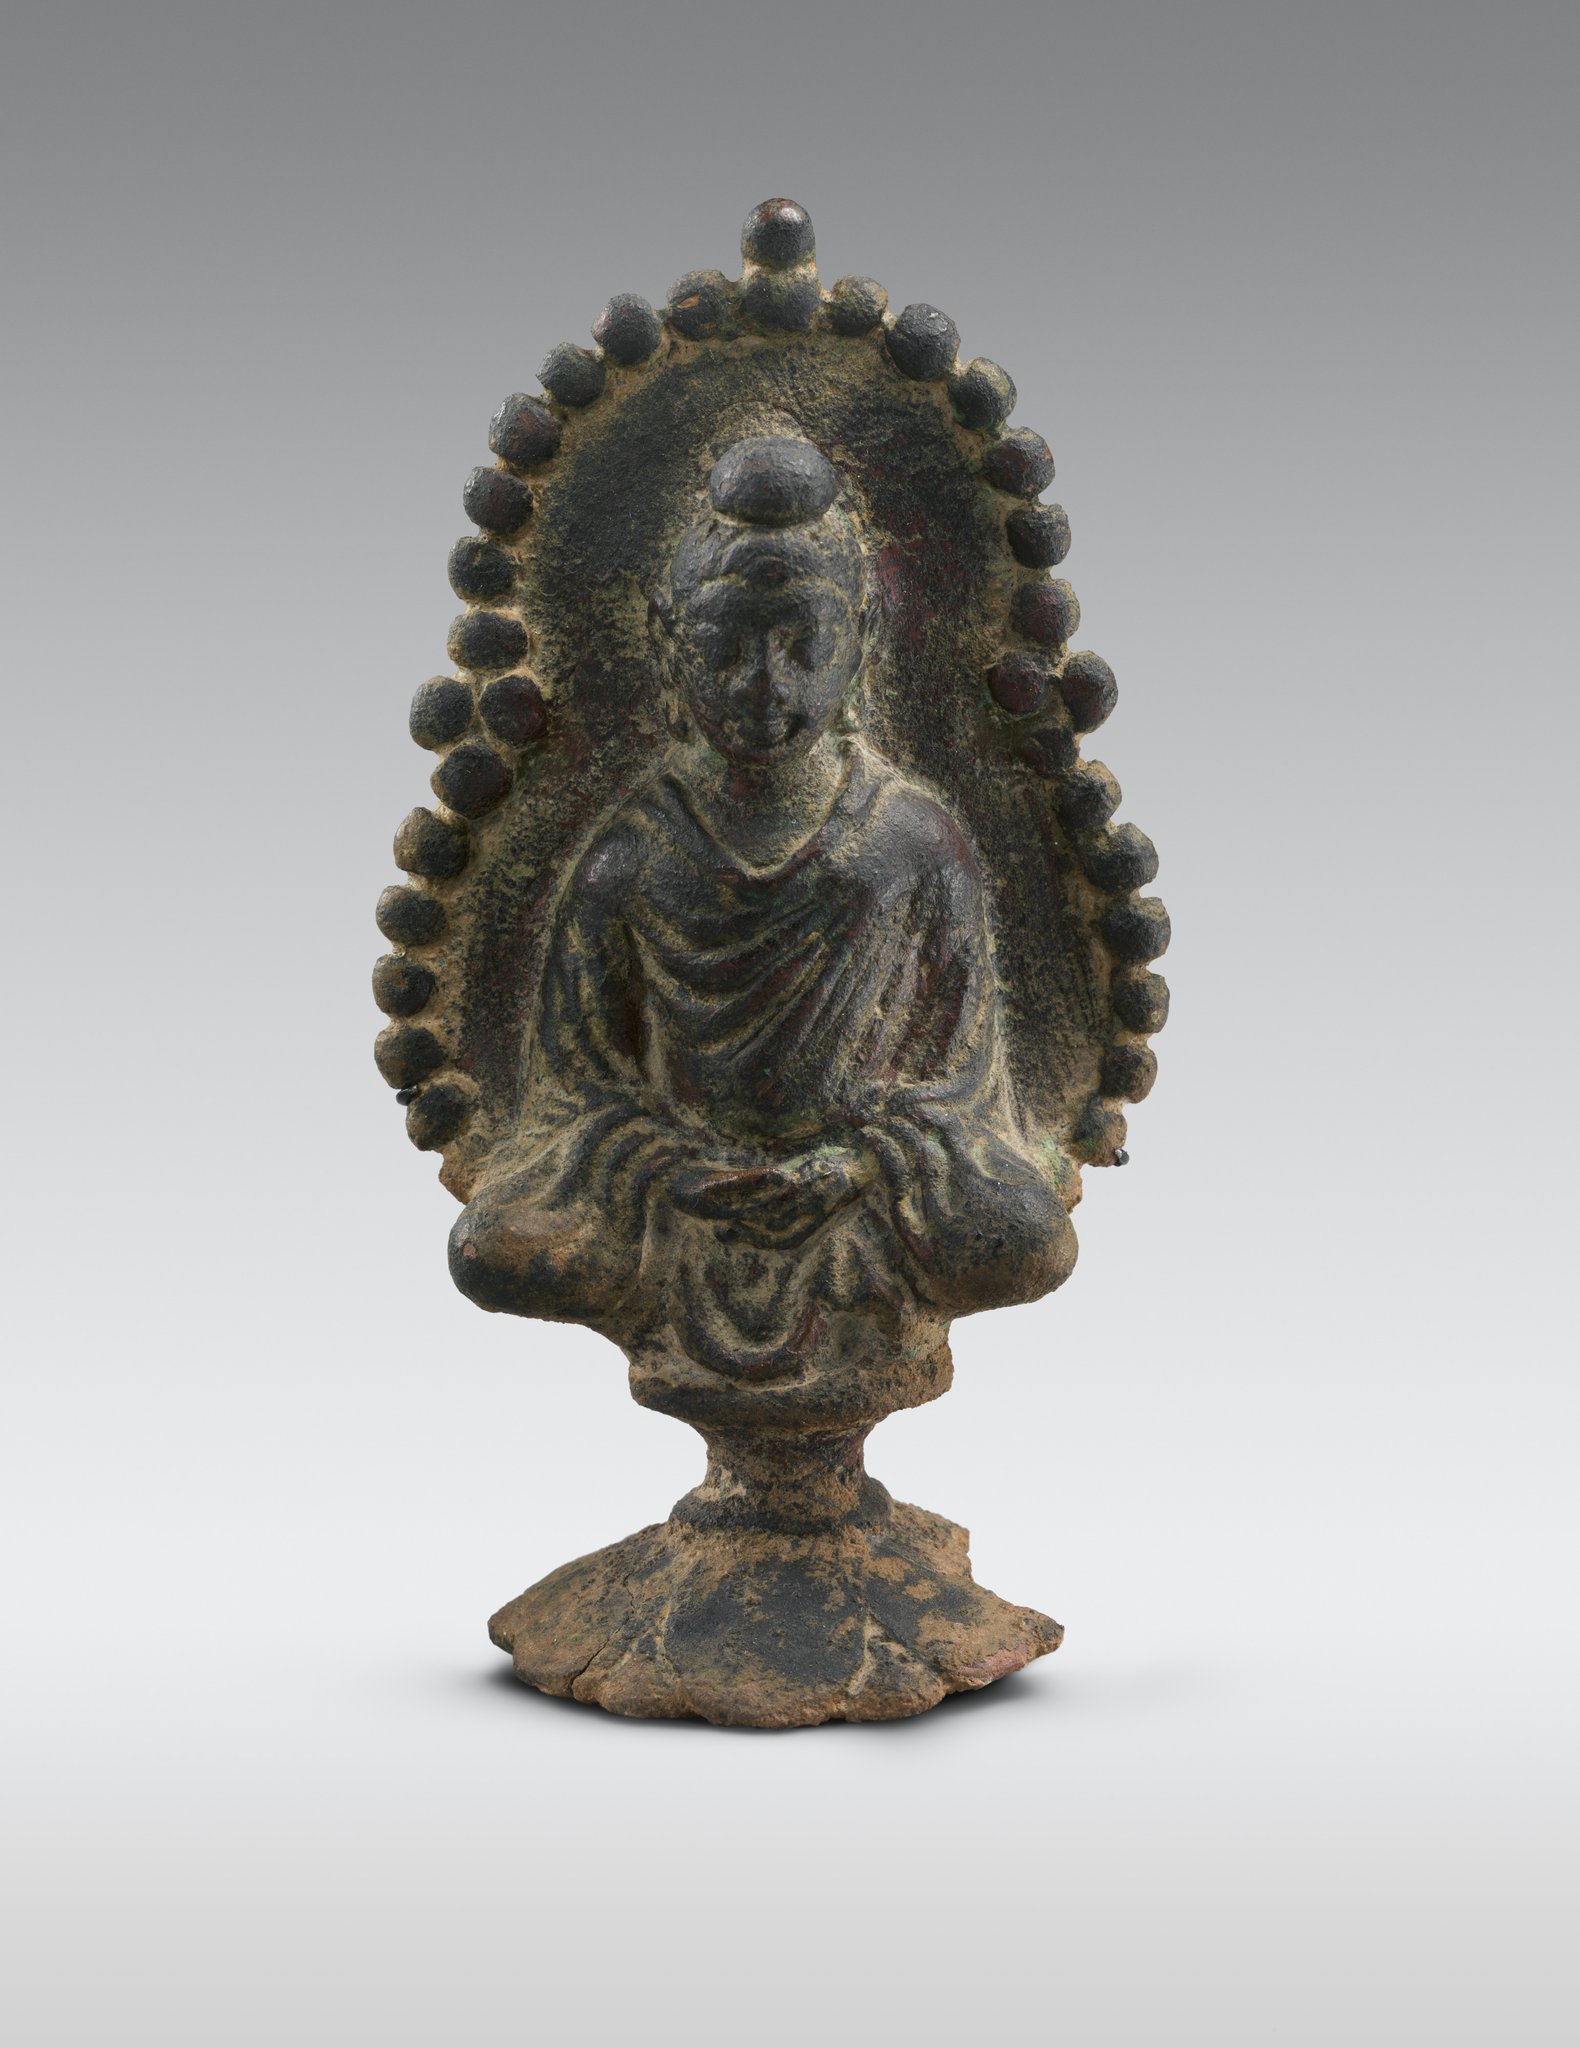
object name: finial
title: Enthroned Buddha Finial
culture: gandhara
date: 301-500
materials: bronze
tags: gandhara,buddha